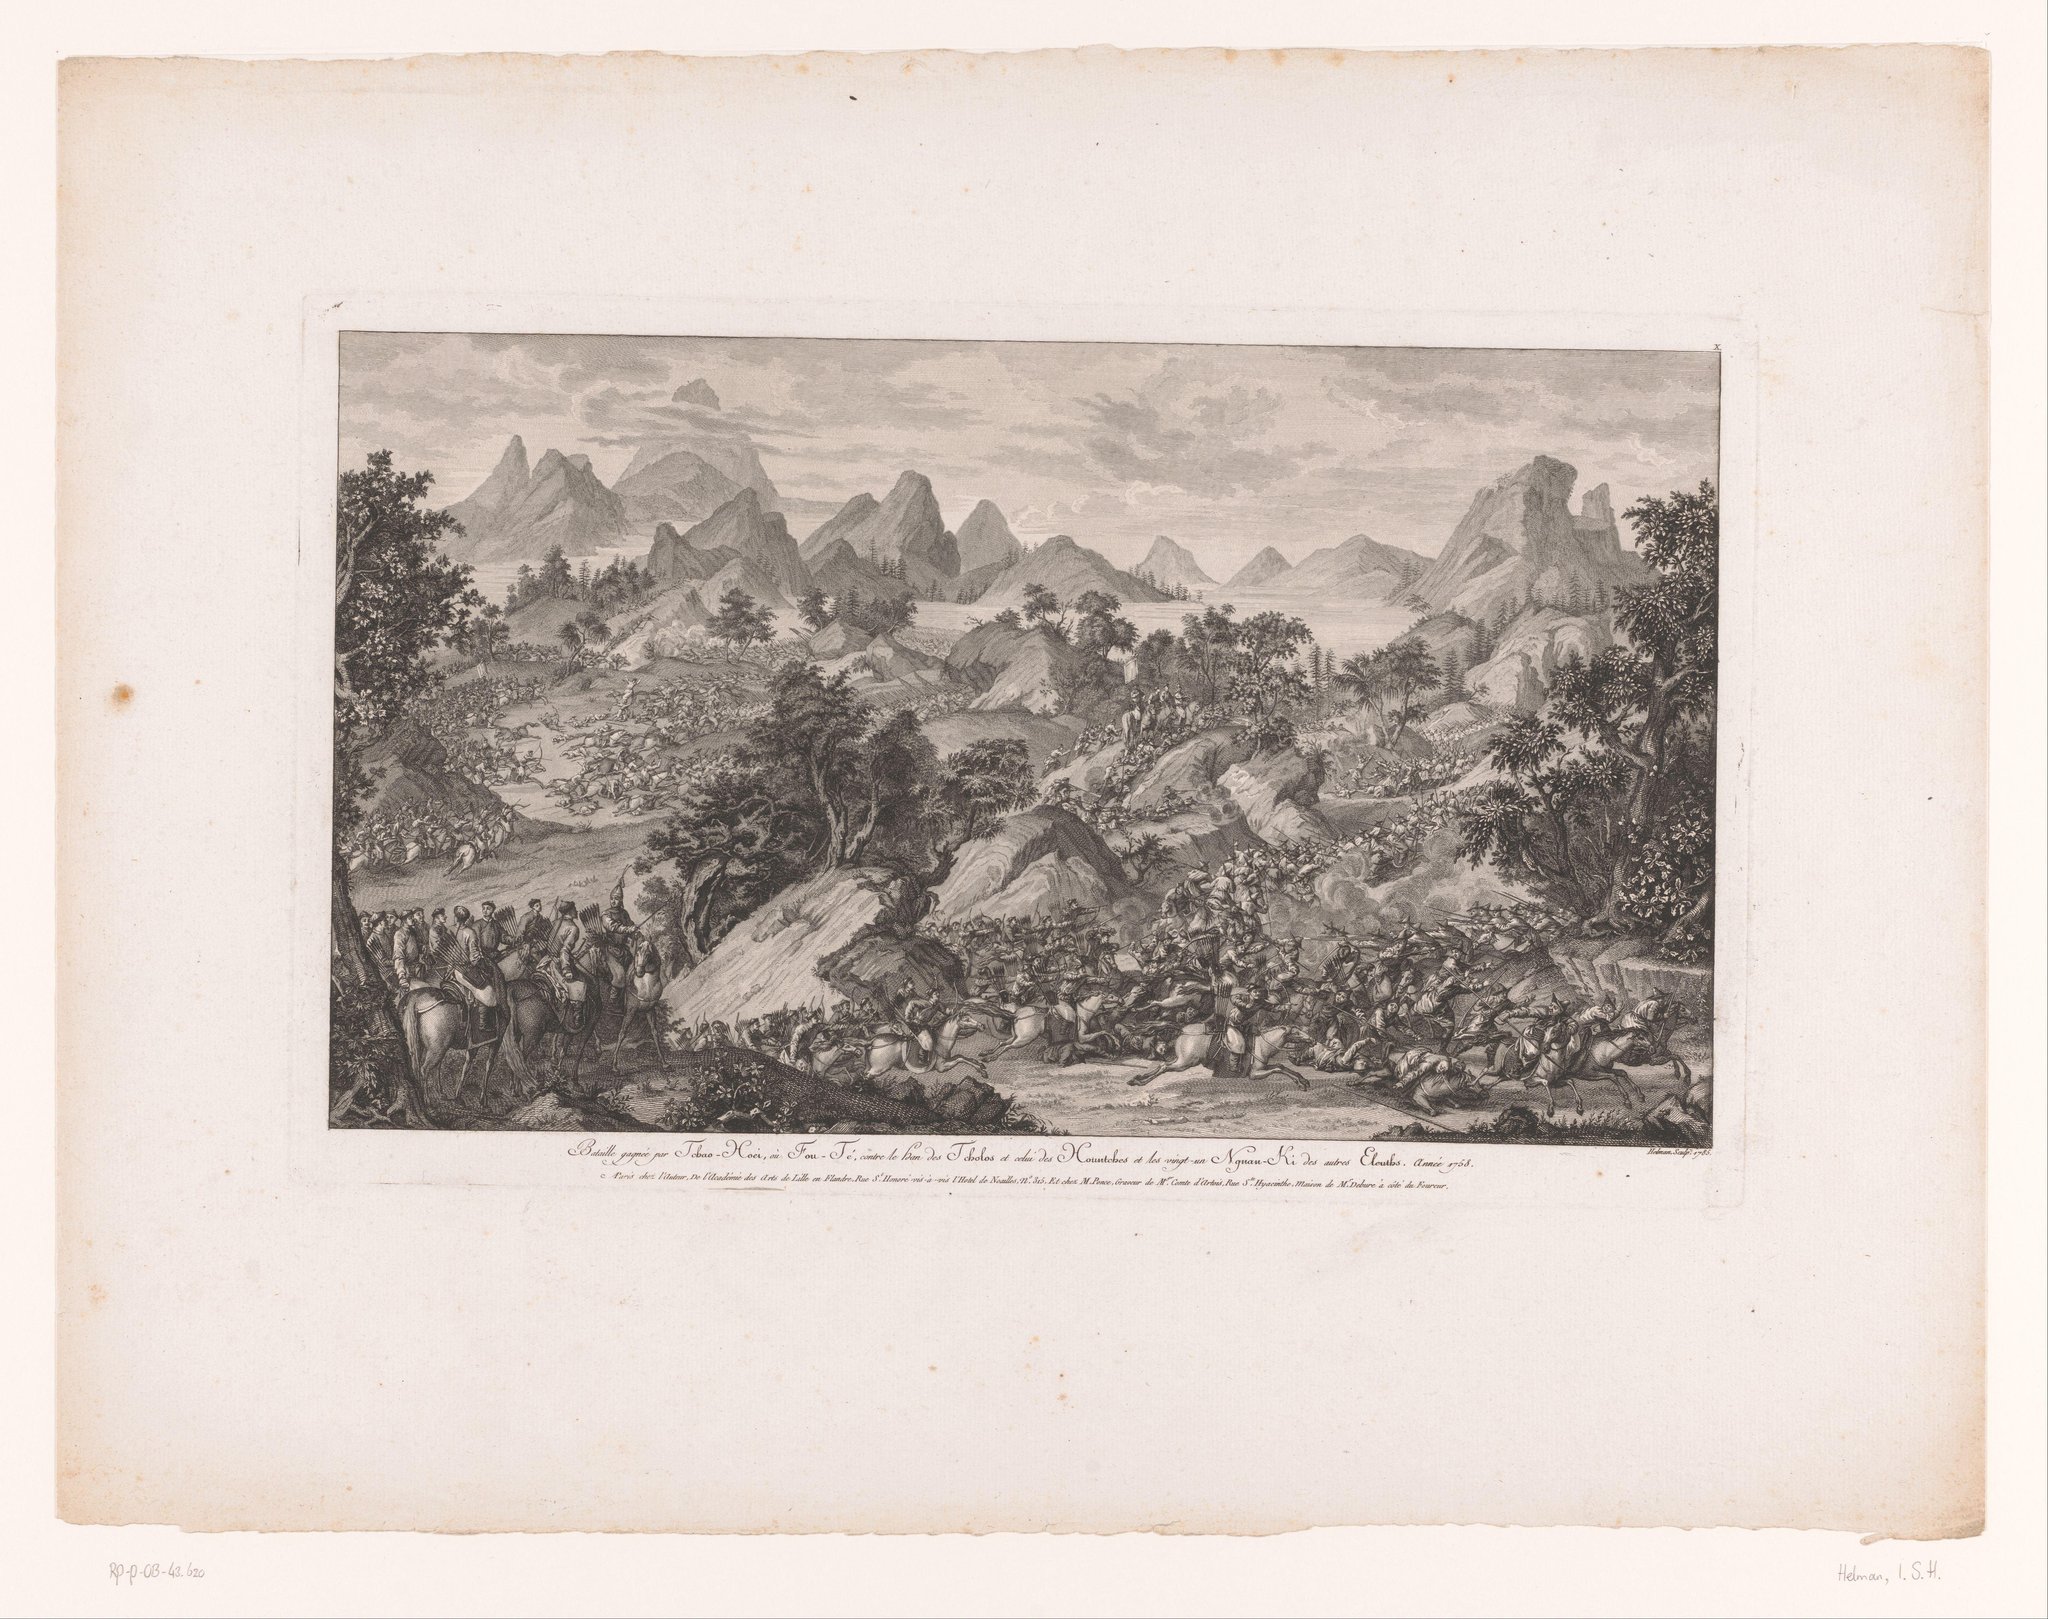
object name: print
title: Conquêtes de l'Empereur de la Chine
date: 1785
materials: paper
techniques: engraving, etching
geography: paris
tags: battle (+ artillery), battle (+ cavalry, horsemen)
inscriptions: collector's mark: Lugt 2228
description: Prent uit een versie van de serie 'Conquêtes de l'Empereur de la Chine' met afbeeldingen van de veroveringen van keizer Qianlong van China, uitgegeven door Helman tussen 1783-1785. Voor twee bladen met bijbehorende beschrijvende tekst, zie RP-P-OB-43.629 en RP-P-OB-43.630.